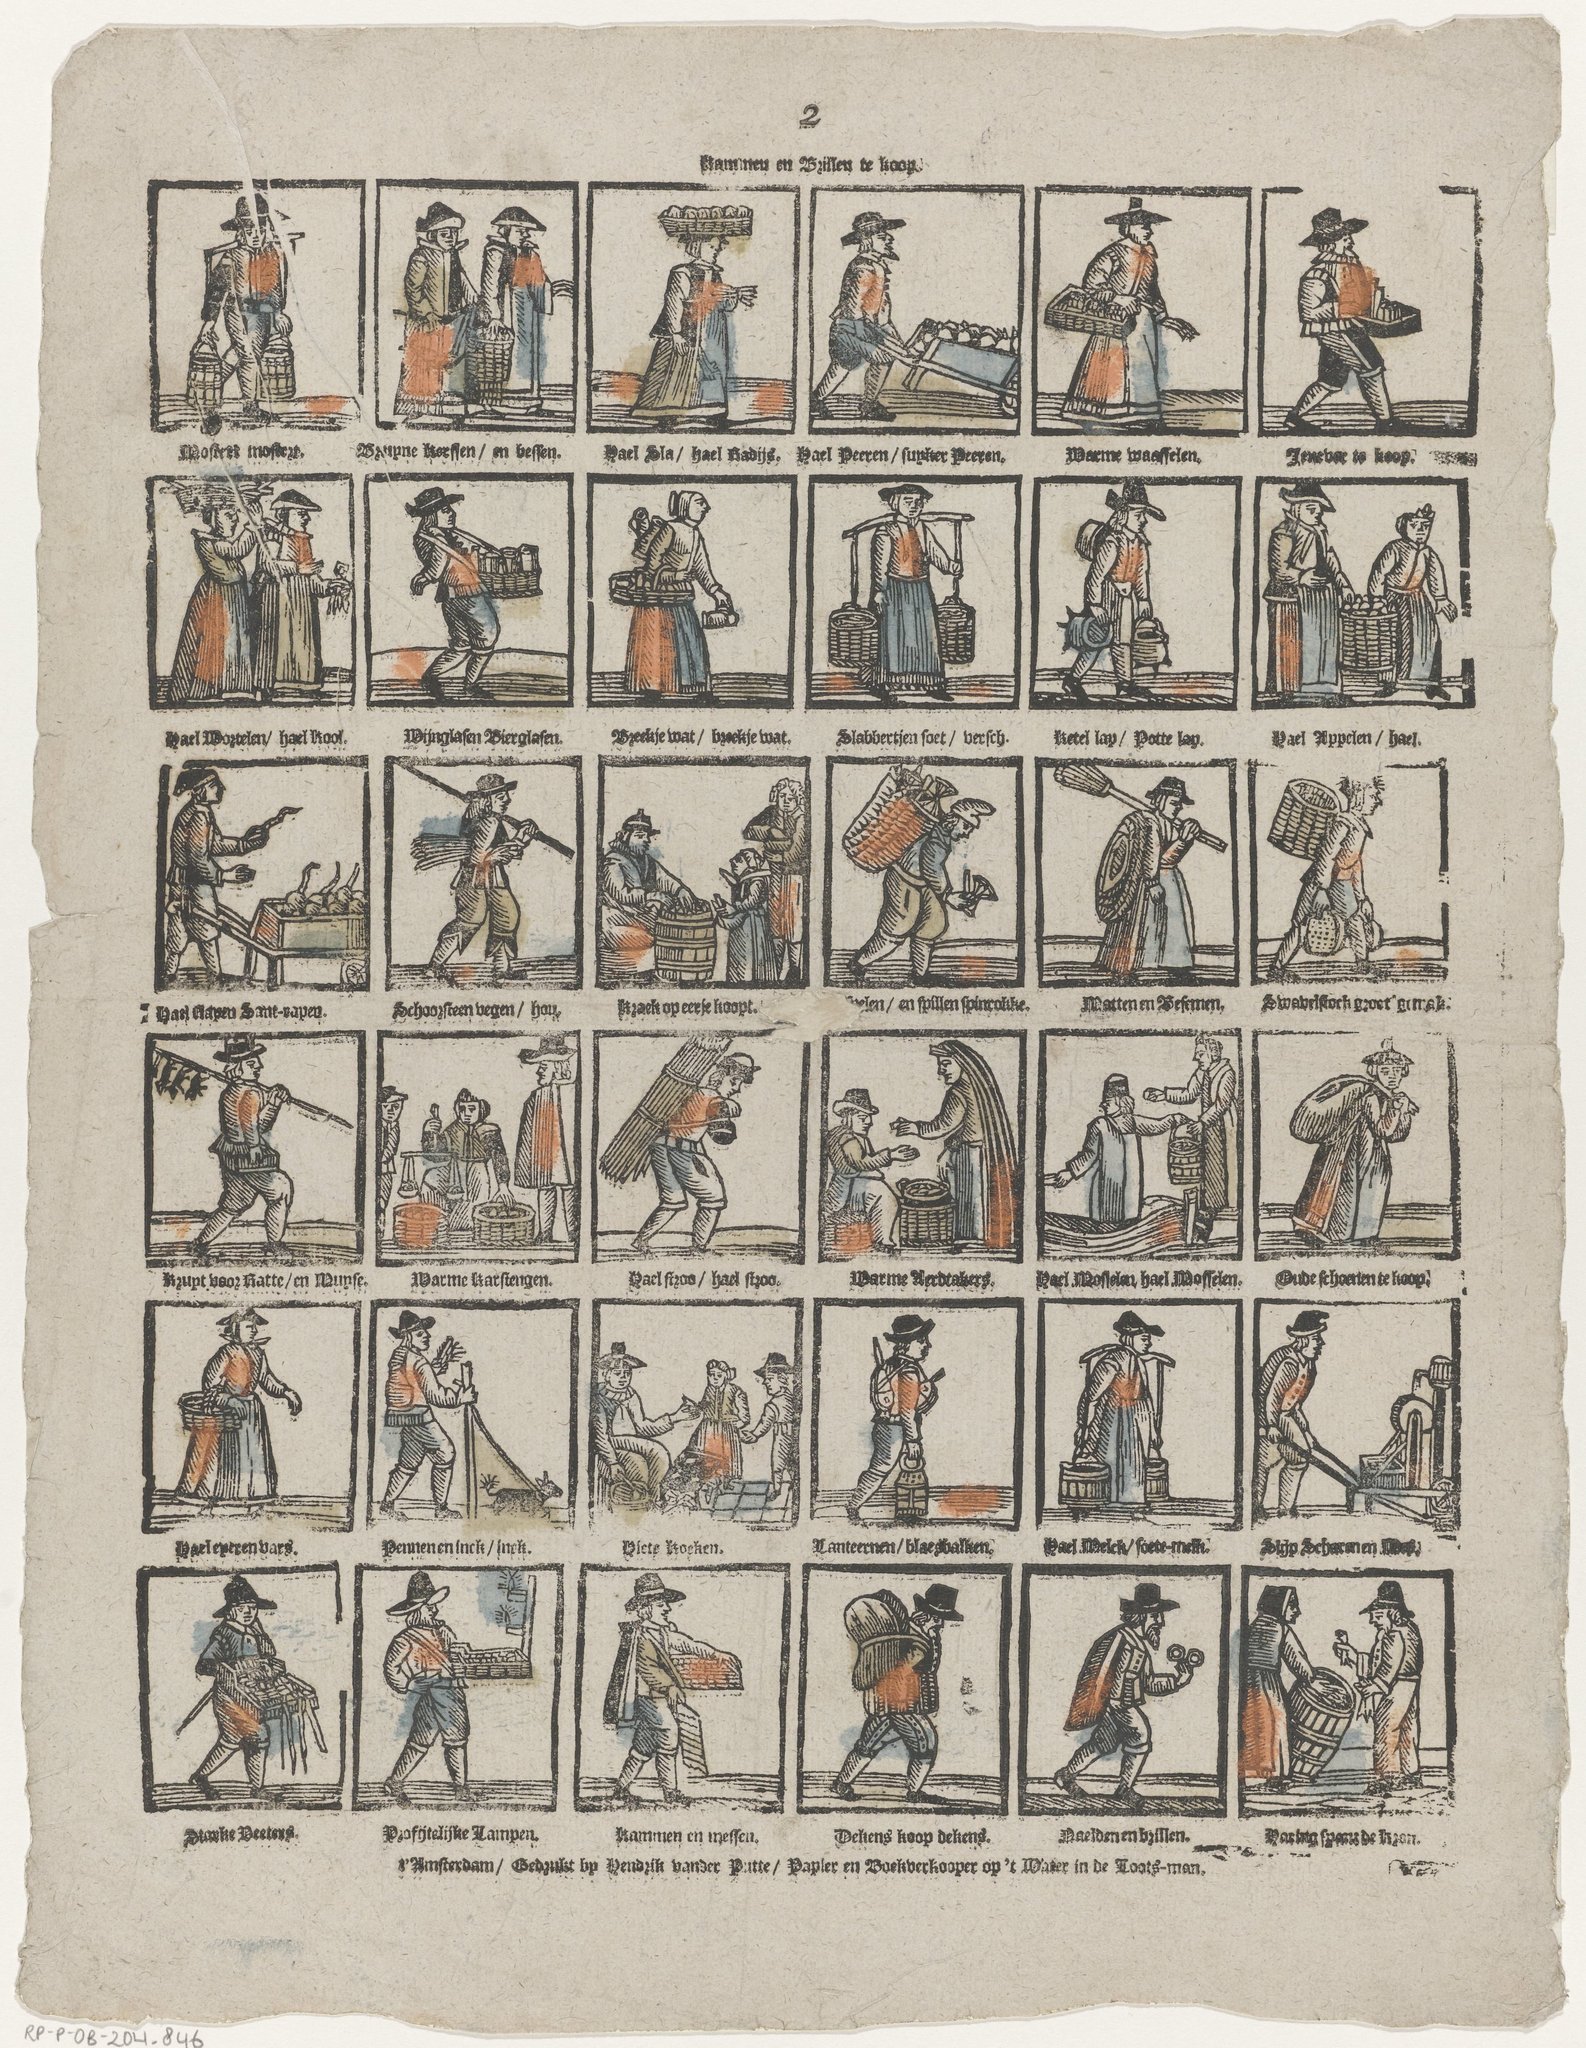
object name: popular print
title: Kammen en brillen te koop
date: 1761-1765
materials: paper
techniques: colour, letterpress printing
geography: amsterdam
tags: street-trader, merchant, salesman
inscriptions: collector's mark: Lugt 2760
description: Blad met 36 voorstellingen van straatverkopers, zoals een slaverkoopster, een wijn- en bierglazenverkoper en een melkmeid. Onder elke afbeelding een onderschrift. Genummerd midden boven: 2.